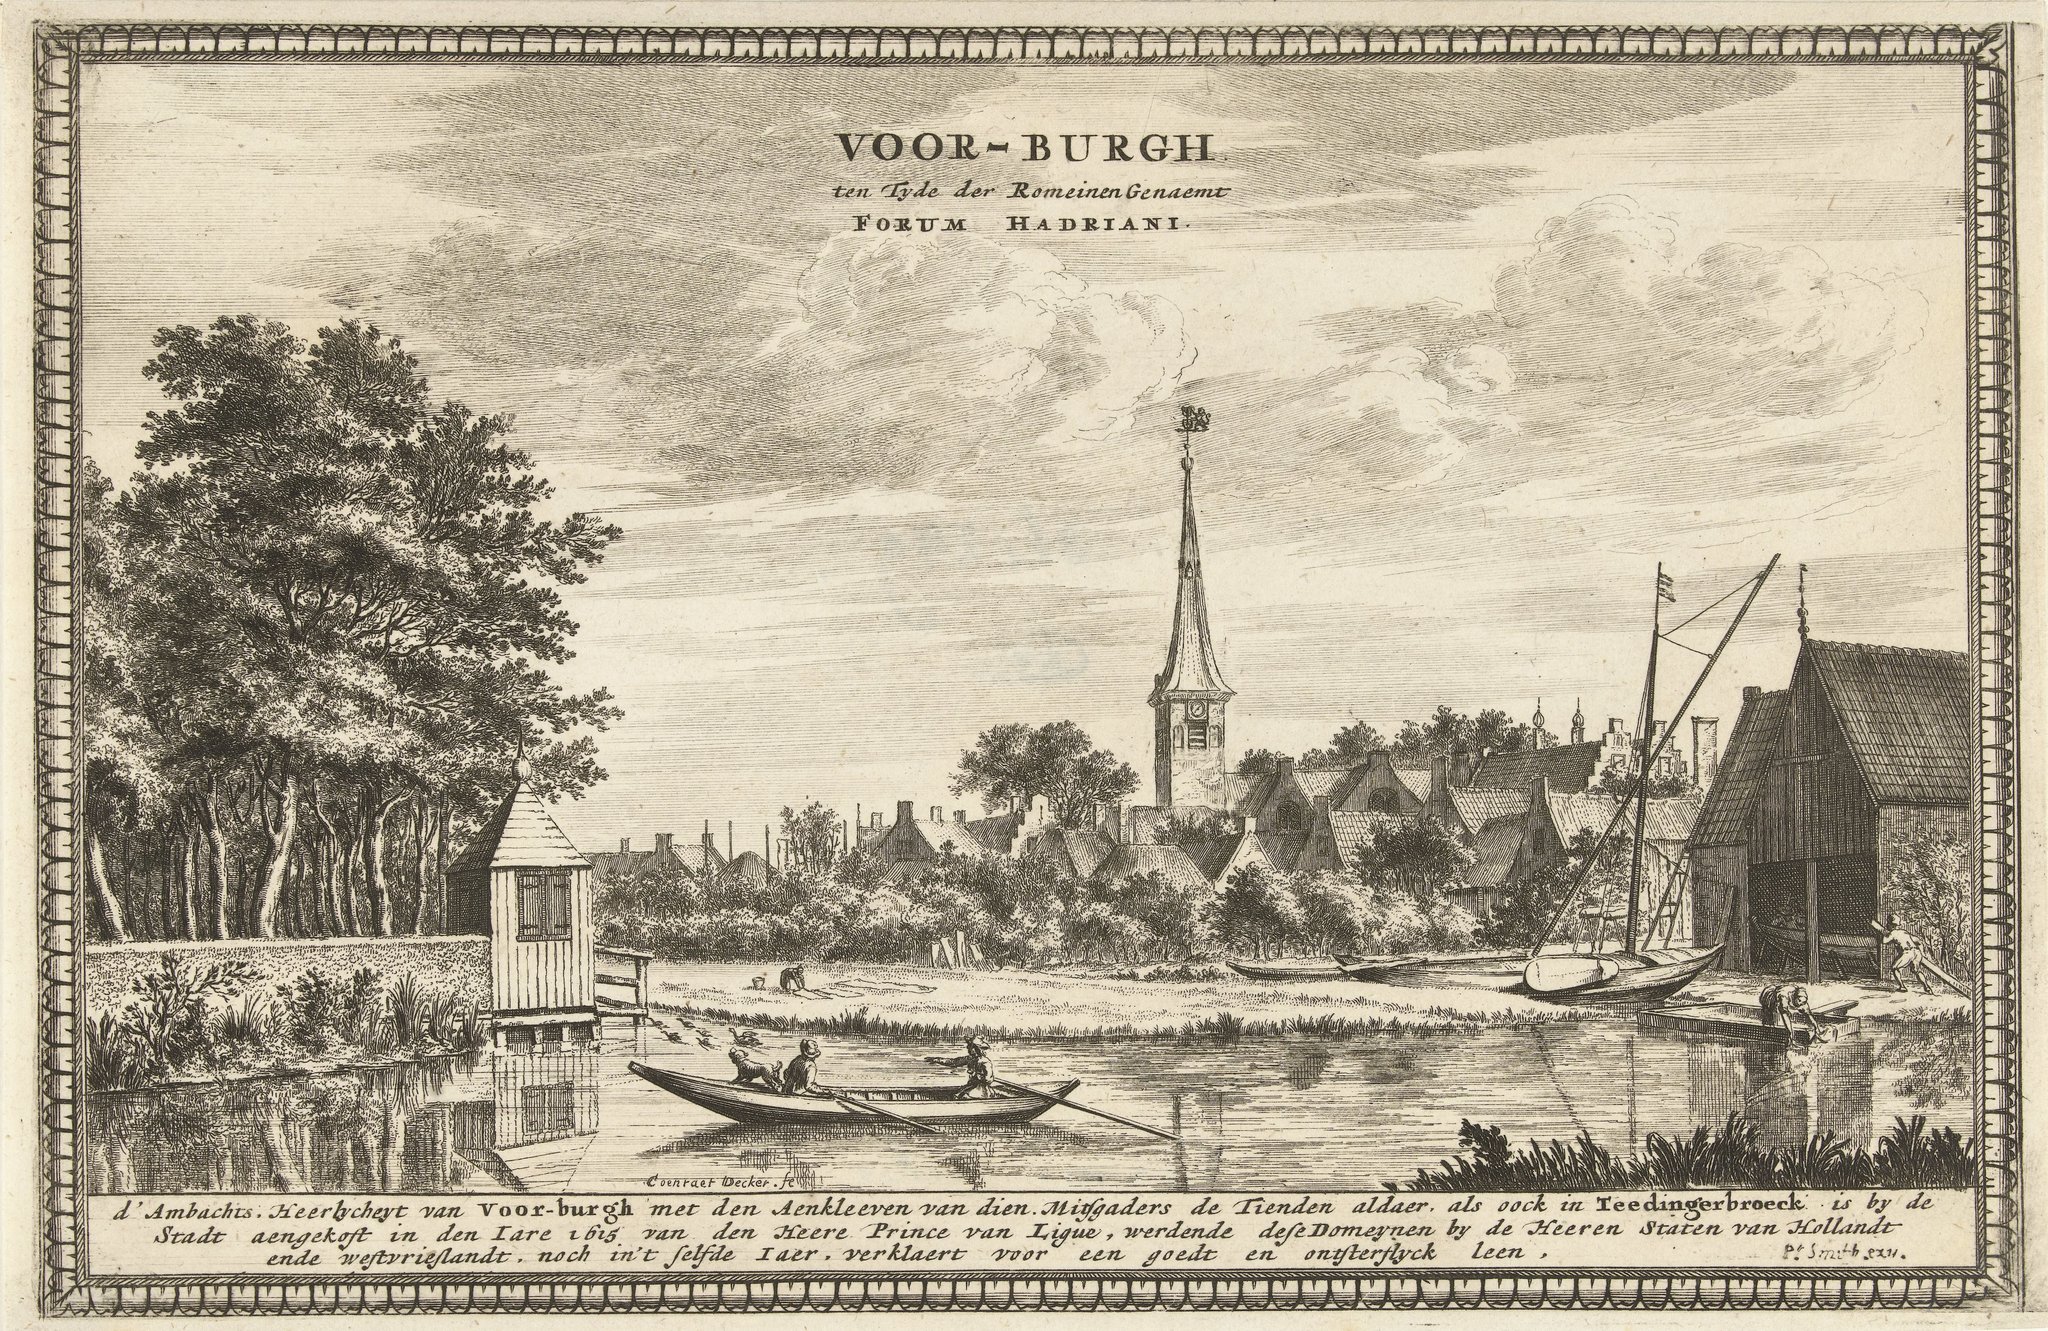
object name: print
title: Voor-burgh ten tyde der Romeinen genaemt Forum Hadriani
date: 1678-1703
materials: paper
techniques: engraving, etching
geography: amsterdam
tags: prospect of village, silhouette of village, shipyard, shipdock, parts of church exterior and annexes: tower, voorburg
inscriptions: collector's mark: Lugt 2760, collector's mark: Lugt 2228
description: Deze prent is in 1678 voor het eerst uitgegeven als onderdeel van de rand van de zogenaamde Kaart Figuratief (Caerte figuratyff / Kaerte figuratyf) van Delft, een wandkaart van Delft. Deze kaart bestaat uit een plattegrond van Delft (RP-P-AO-11-8A) met daaromheen een rand. De rand bestaat uit een profiel van Delft (RP-P-AO-11-11), een profiel van Delfshaven met daaronder de wapenschilden van de burgemeesters van de stad (RP-P-AO-13-51-1 en RP-P-AO-13-51-2), 24 kleinere prenten (kaarten, afbeeldingen van gebouwen en graven van bekende personen, o.a. RP-P-AO-11-15, RP-P-AO-11-16, RP-P-AO-11-17, RP-P-AO-11-18, RP-P-AO-11-19, RP-P-AO-11-20, RP-P-AO-11-21, RP-P-AO-11-23, RP-P-AO-11-24, RP-P-AO-11-27, RP-P-AO-11-28, RP-P-AO-11-29, RP-P-AO-11-30, RP-P-AO-11-31, RP-P-AO-11-33C, RP-P-AO-11-34, RP-P-AO-11-35, RP-P-AO-11-35-2, RP-P-AO-13-49, RP-P-AO-13-52, RP-P-AO-13-53, RP-P-AO-13-54-1 en RP-P-1909-6463) en een beschrijving van de stad (RP-P-AO-11-8E). De eerste druk van deze Kaart Figuratief (1678) werd, in opdracht van het Delftse stadsbestuur, verzorgd door Pieter Smith. In 1680 leverde Smith ook vijfhonderd afdrukken van de randprenten die bestemd waren voor Dirk Evertsz. Bleyswijcks 'Beschryvinge der stadt Delft' (1667) en het tweede deel: 'Vervolg van de beschryvinge der stadt Delft' (1680). In het tweede deel zat een bijlage waarin beschreven staat welke prenten waar in het eerste en tweede deel ingebonden dienden te worden. Een deel van de prenten was dus bestemd voor het in 1667 verschenen eerste deel en kon met het verschijnen van het tweede deel in 1680 alsnog worden ingebonden. Hierdoor wordt vaak gedacht dat de prenten uit het eerste deel dateren uit 1667, hetgeen niet klopt. De huidige prent is zodoende ook gebruikt in: Bleyswijck, Dirk Evertsz. Beschryvinge der stadt Delft, betreffende des selfs situatie, oorsprong en ouderdom, opkomst en voortgangh (…). Delft: Arnold Bon, 1667 (prenten vanaf 1680 ingebonden), p. 104. Pieter Mortier (I) verzorgde in 1703, tevens in opdracht van het stadsbestuur, een tweede uitgave van de Kaart Figuratief. Voor deze druk bracht graveur Thomas van der Wilt enkele aanpassingen aan op de platen van de plattegrond. De randplaten lijken, op de plaat met de wapens van de burgemeesters na, ongewijzigd te zijn gebleven. De plattegrond is in 1752, waarschijnlijk zonder de randprenten, opnieuw uitgegeven. Of de huidige prent is gebruikt als onderdeel van de rand van de Kaart Figuratief uit 1678 of 1703, of is gebruikt in 'Beschryvinge der stadt Delft' (1667, prenten 1680), is niet na te gaan.